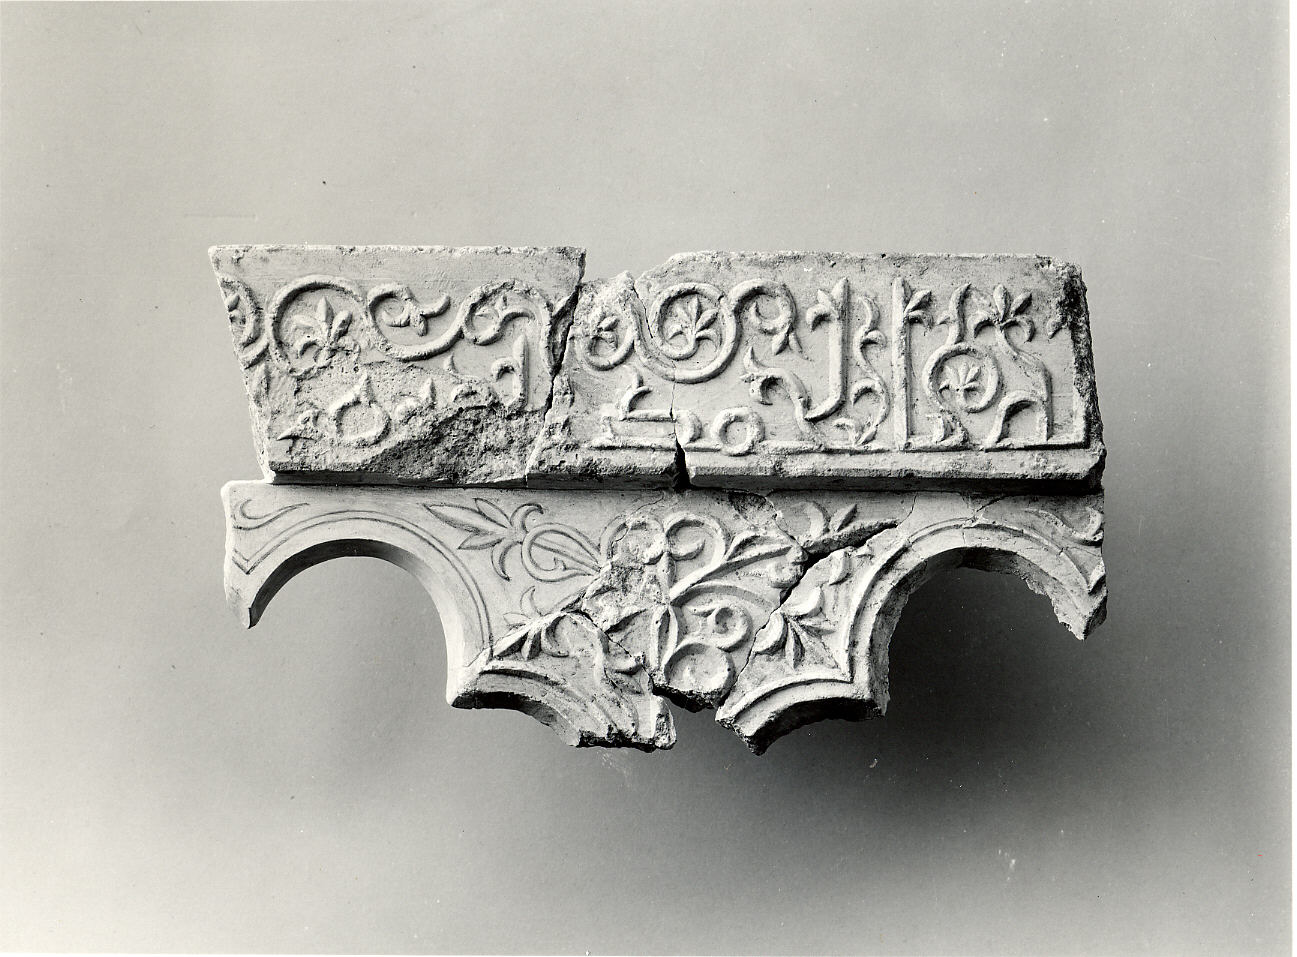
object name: window fragment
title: Fragment of a Window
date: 801-1000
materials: plaster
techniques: molding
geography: iran